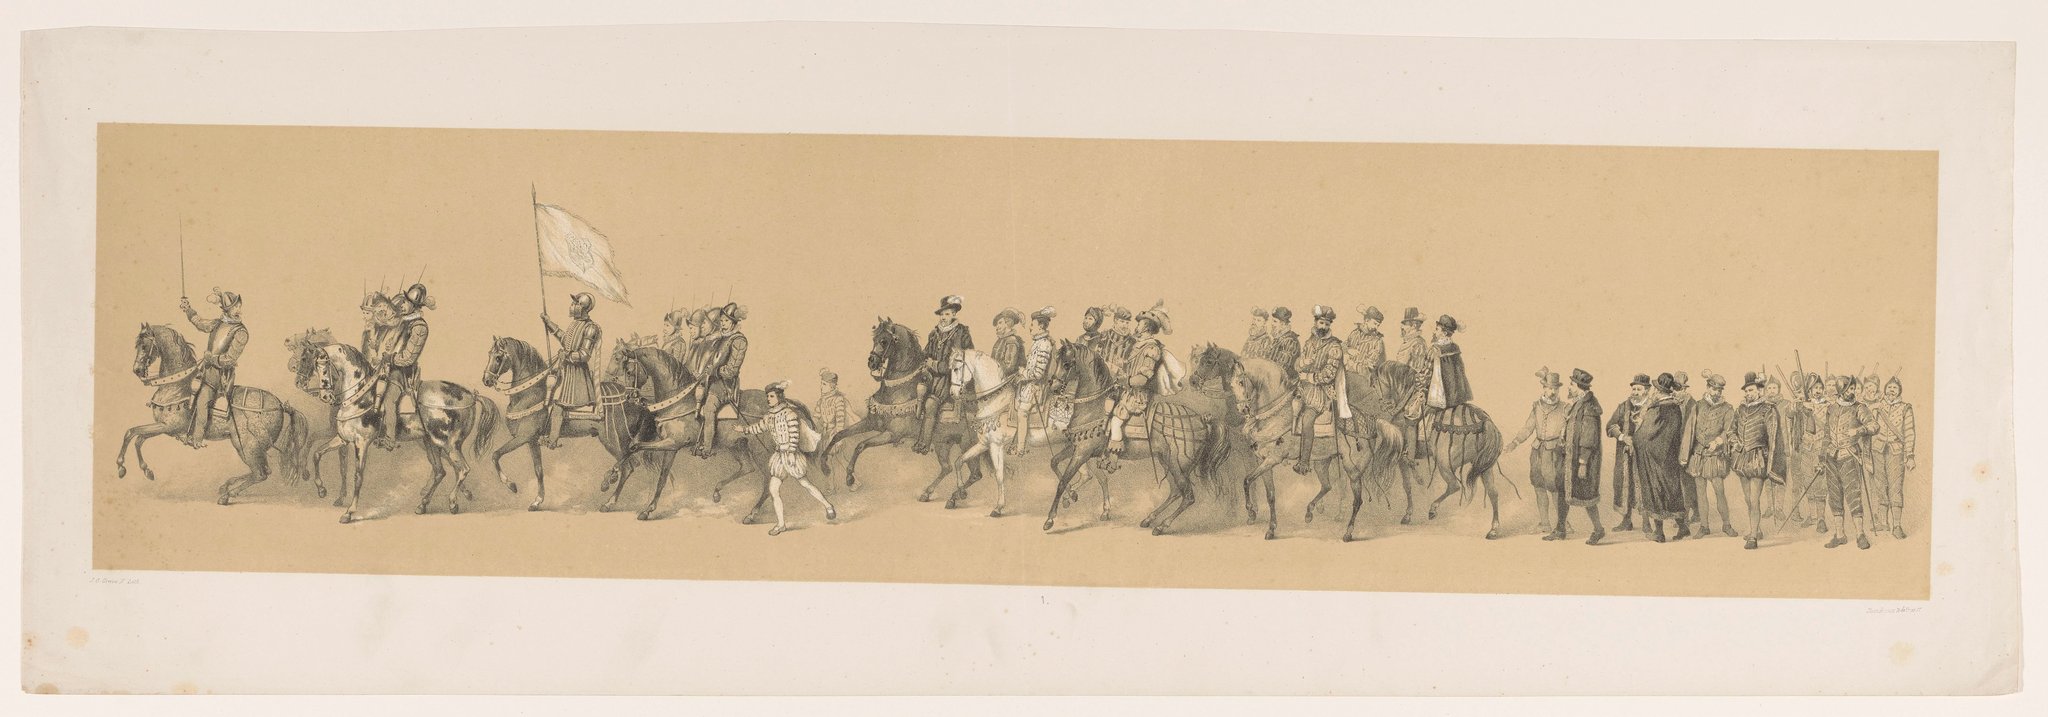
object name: print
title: Eerste deel van een zestiende-eeuwse optocht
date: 1847-1891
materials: paper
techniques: lithograph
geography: amsterdam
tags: ceremonial celebration of installation of a ruler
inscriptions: collector's mark: Lugt 2228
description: Optocht met soldaten te paard, pages te voet en raadslieden te paard. Ze zijn alle gekleed in zestiende-eeuwse kledingdracht. Een van de ruiters houdt een vlag omhoog.